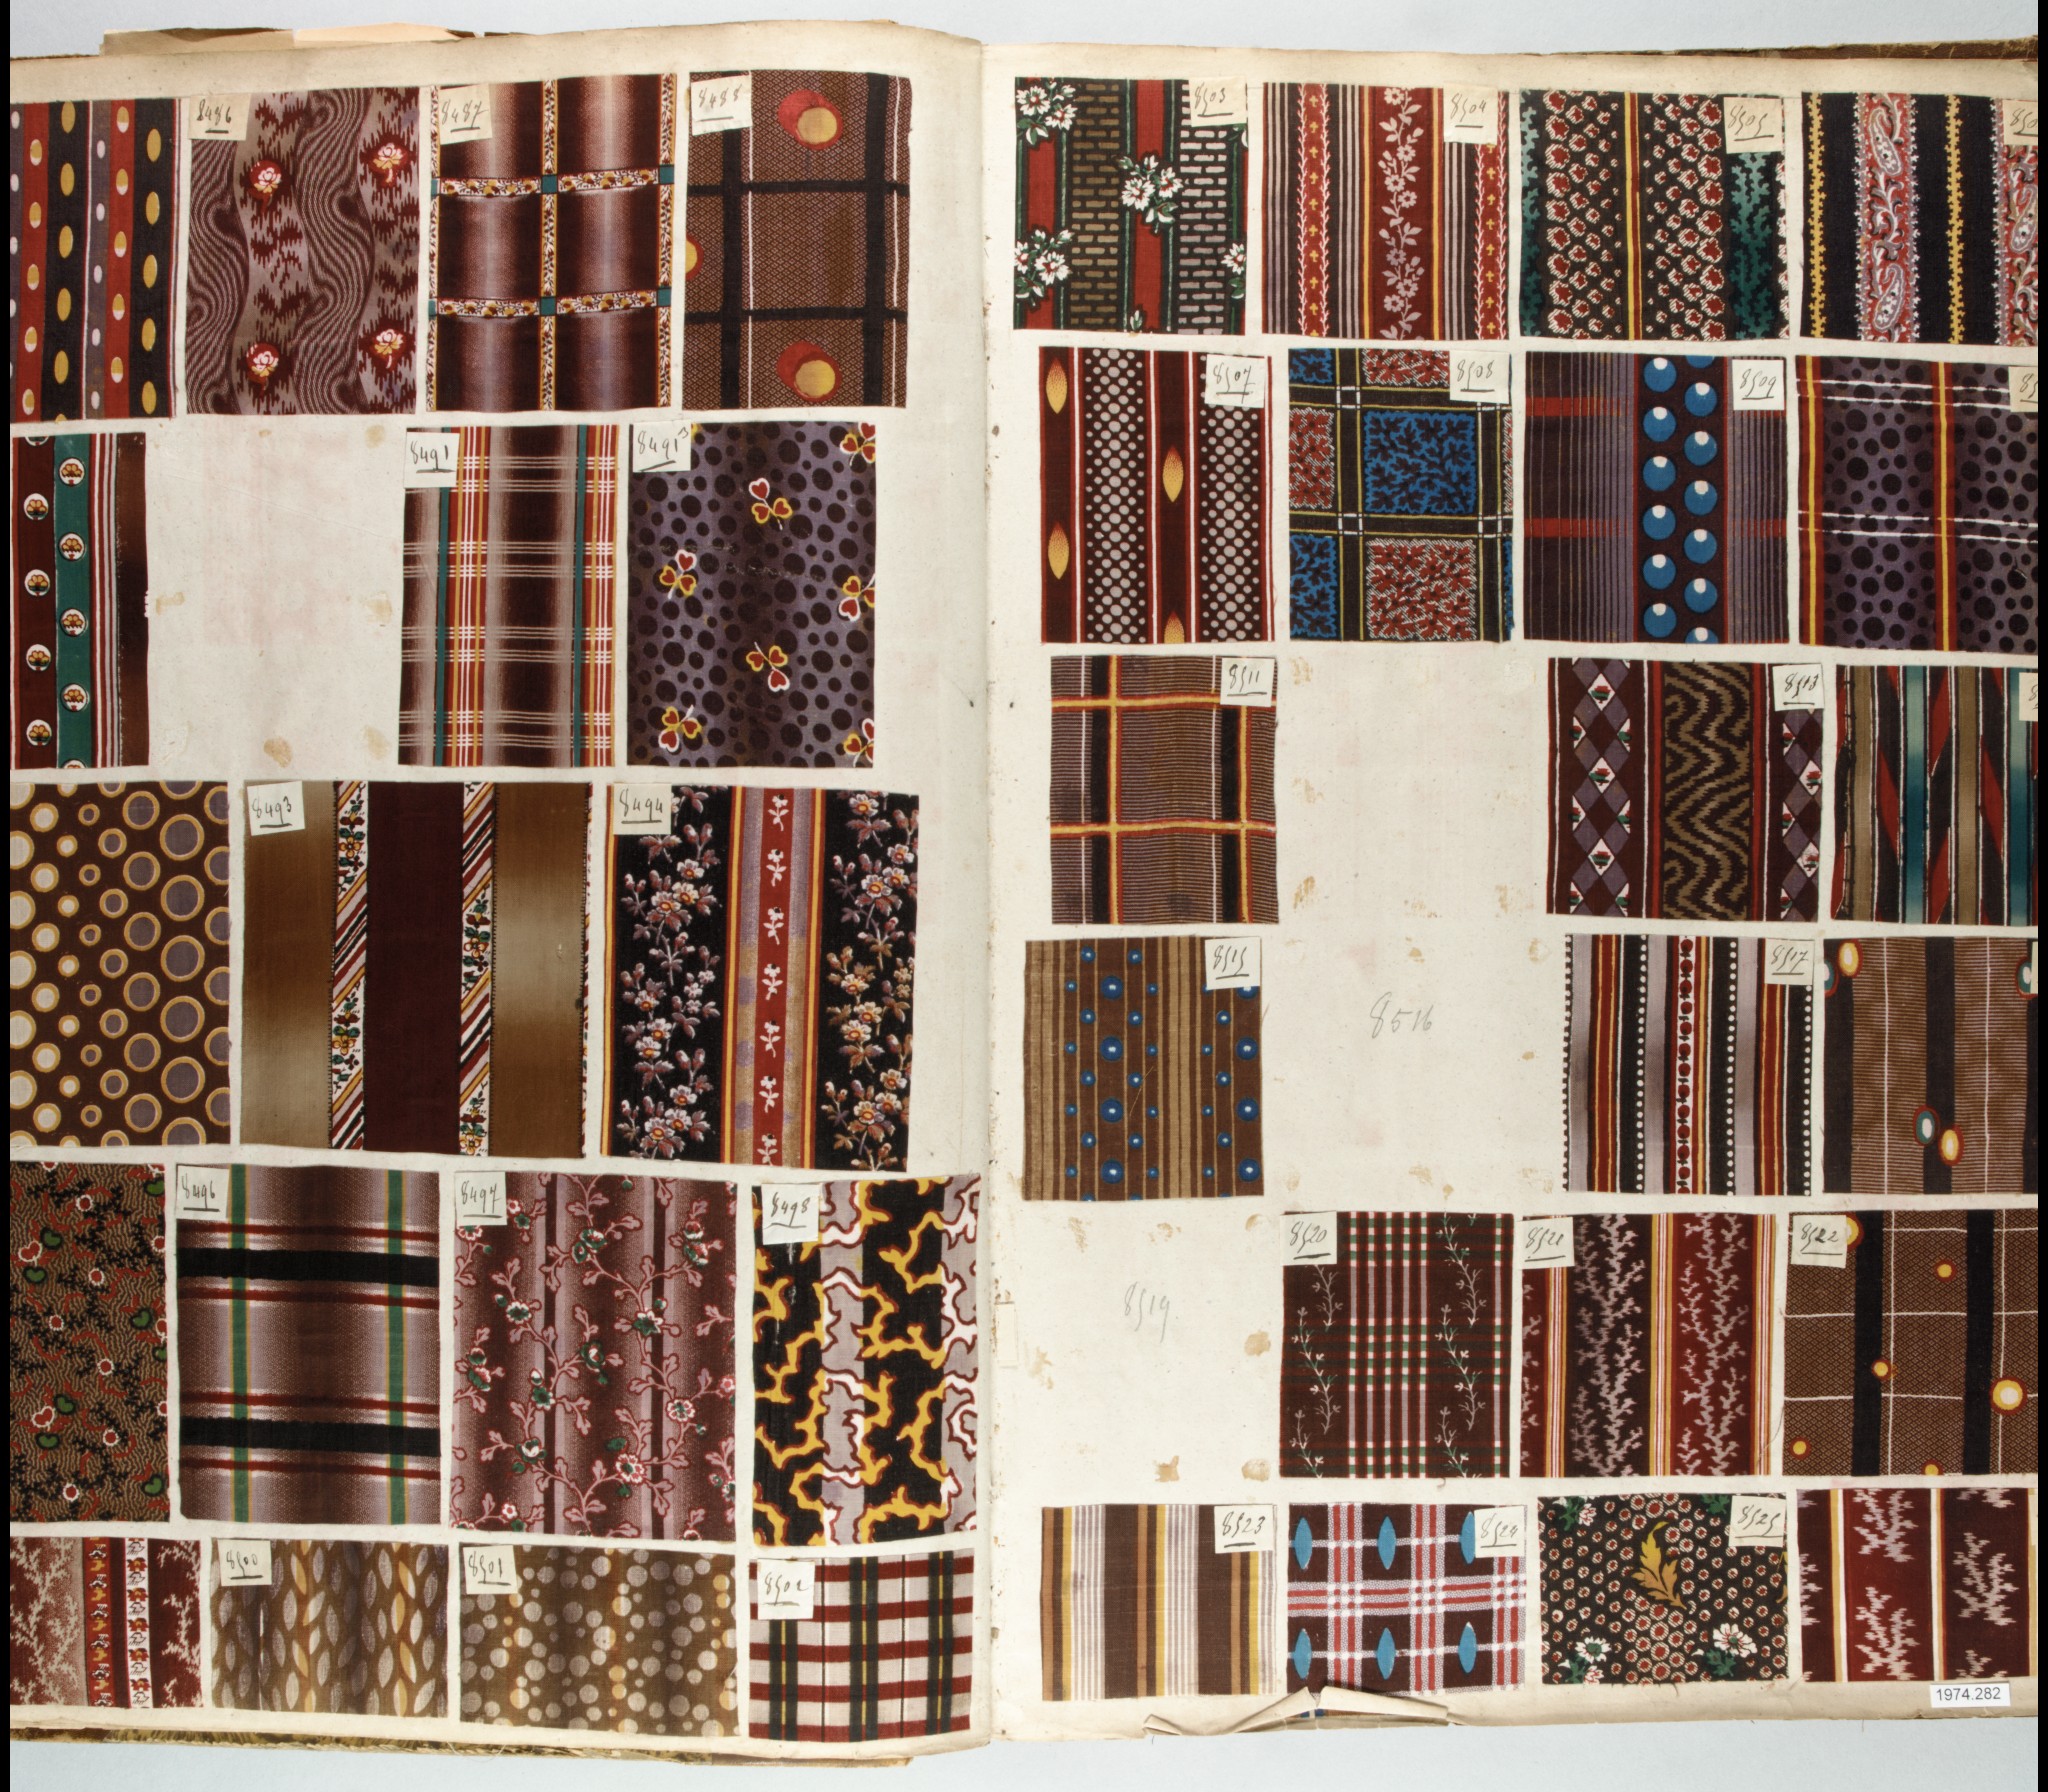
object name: sample book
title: Textile Sample Book labeled "Indiennes et Organdis"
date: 1840-1845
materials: ink, paper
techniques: printing